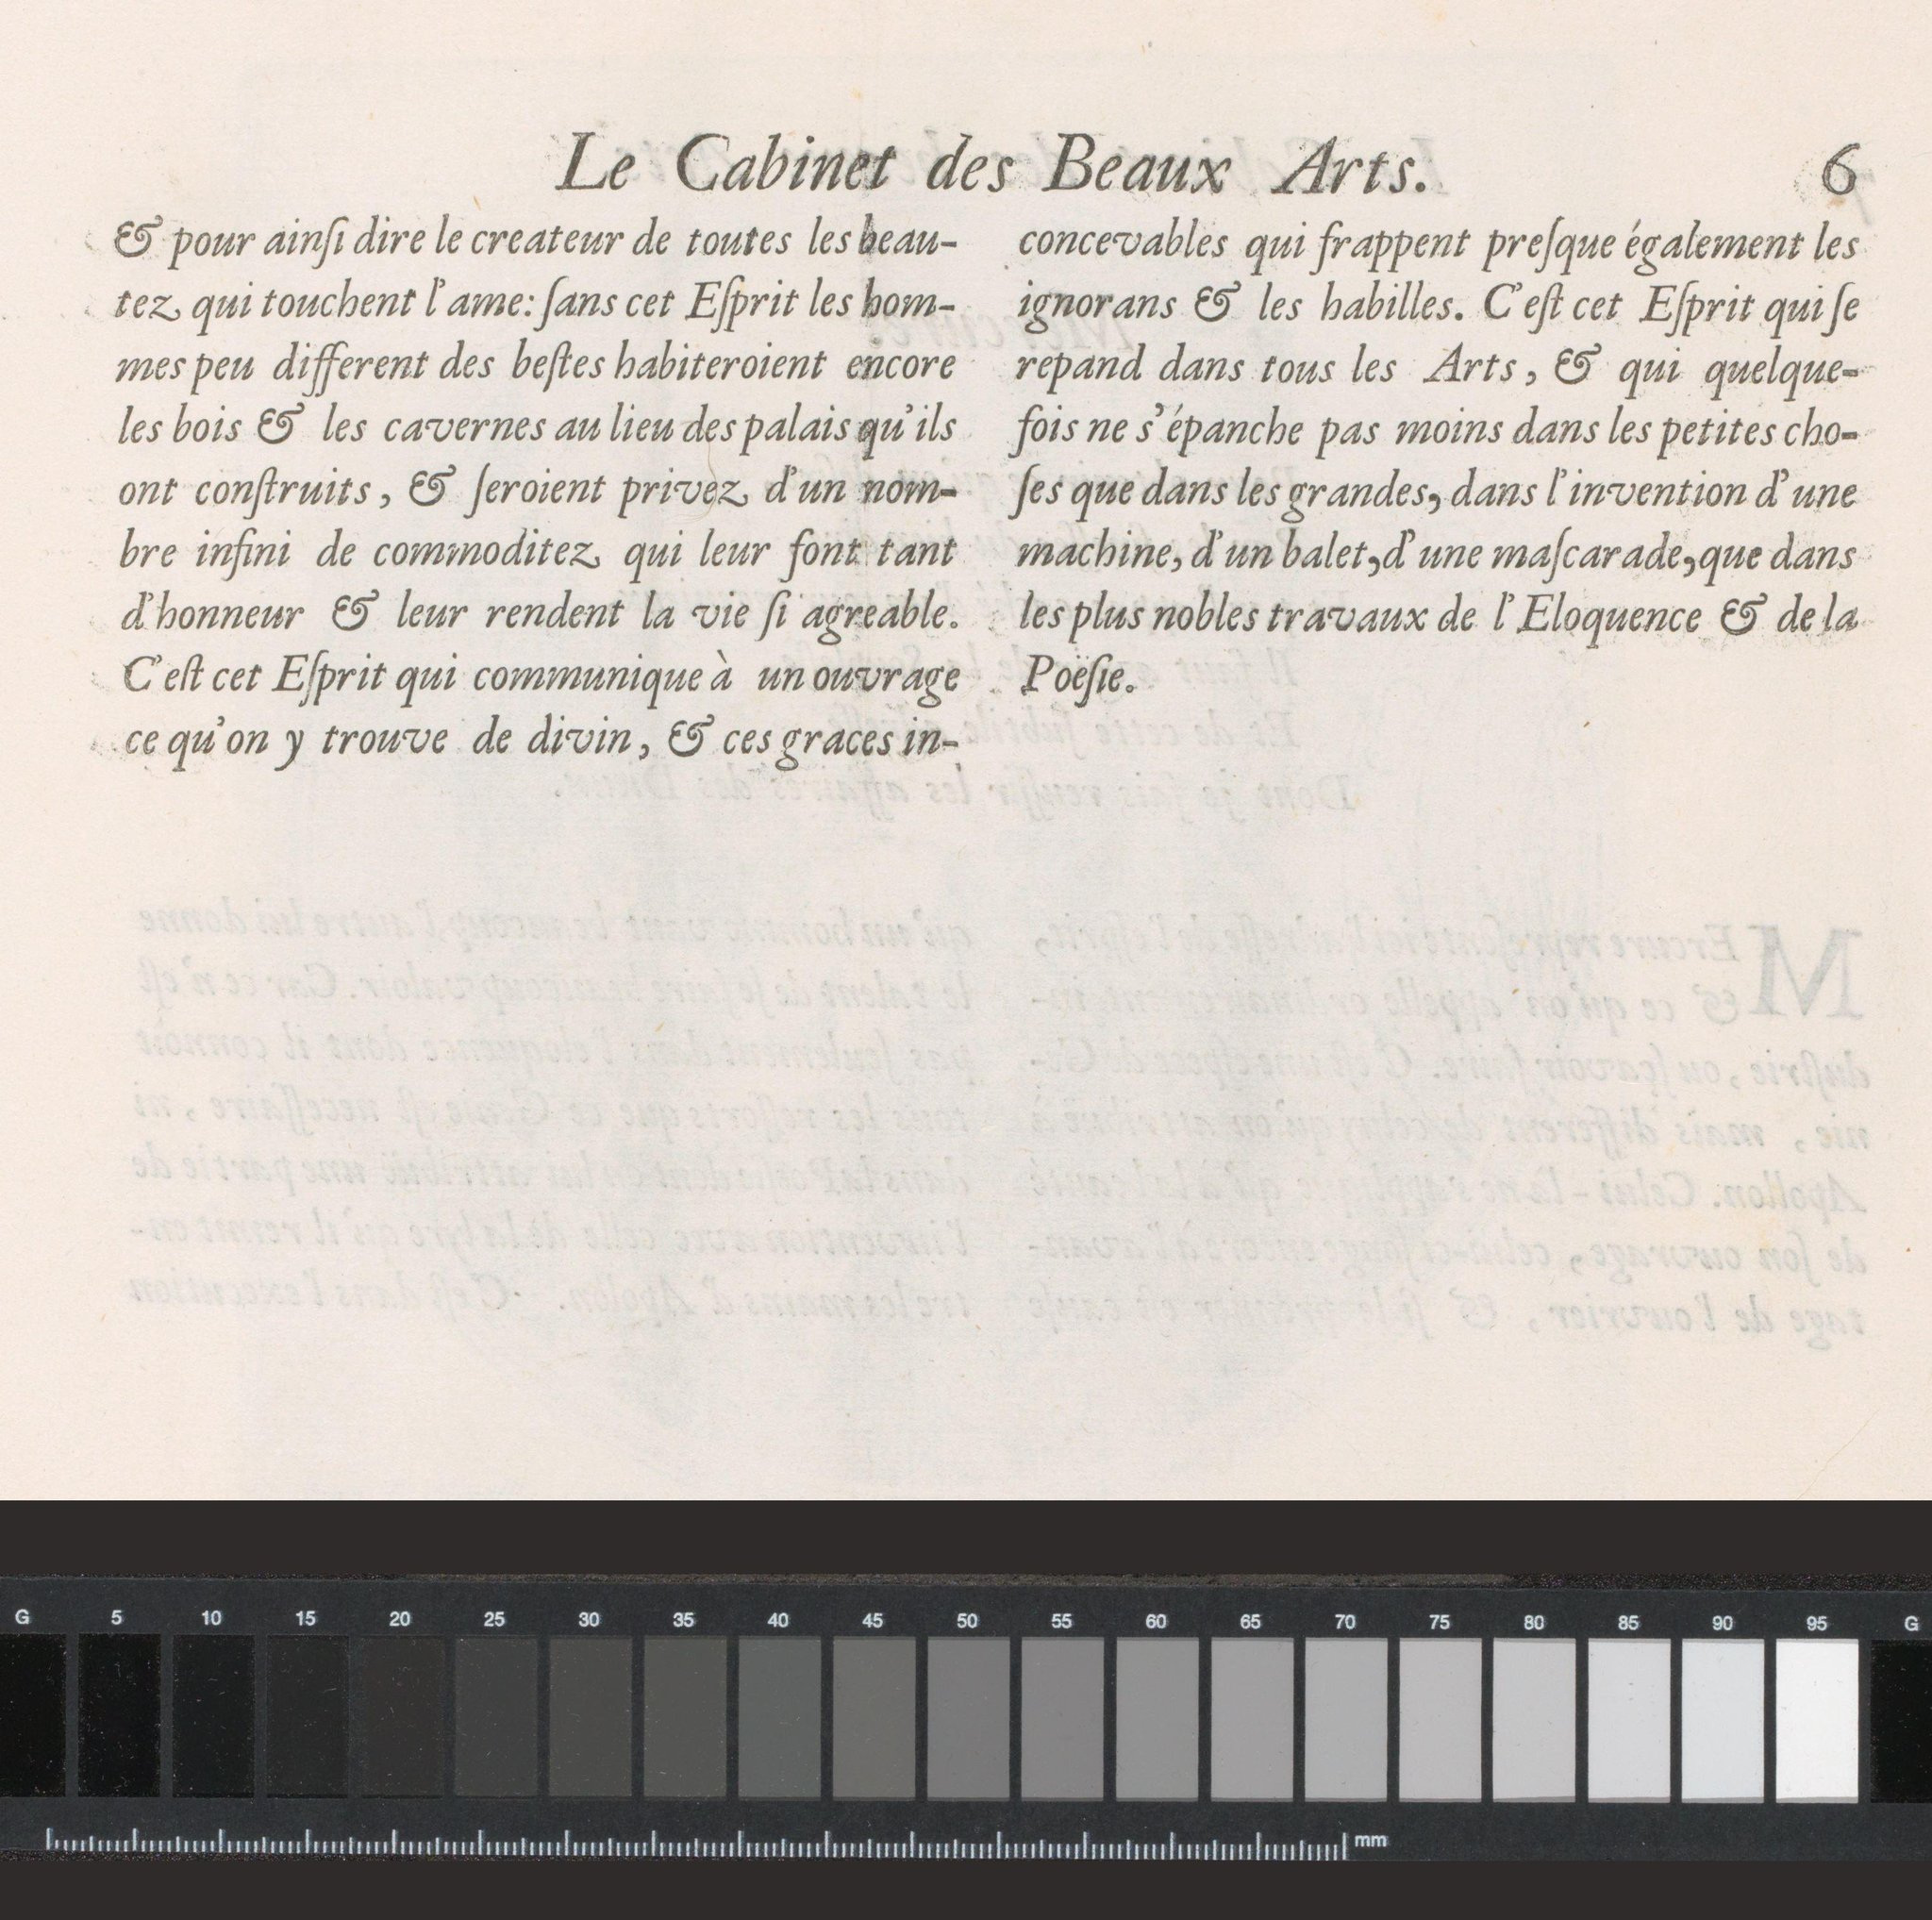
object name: album leaf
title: Tekstblad met verklaring van de prent van Apollo, p. 6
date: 1695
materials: paper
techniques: letterpress printing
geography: paris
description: Verklaring van de prent met voorstelling van Apollo (ontbreekt in album) in het Frans. Pagina 6. Tekstblad maakt deel uit van een album.